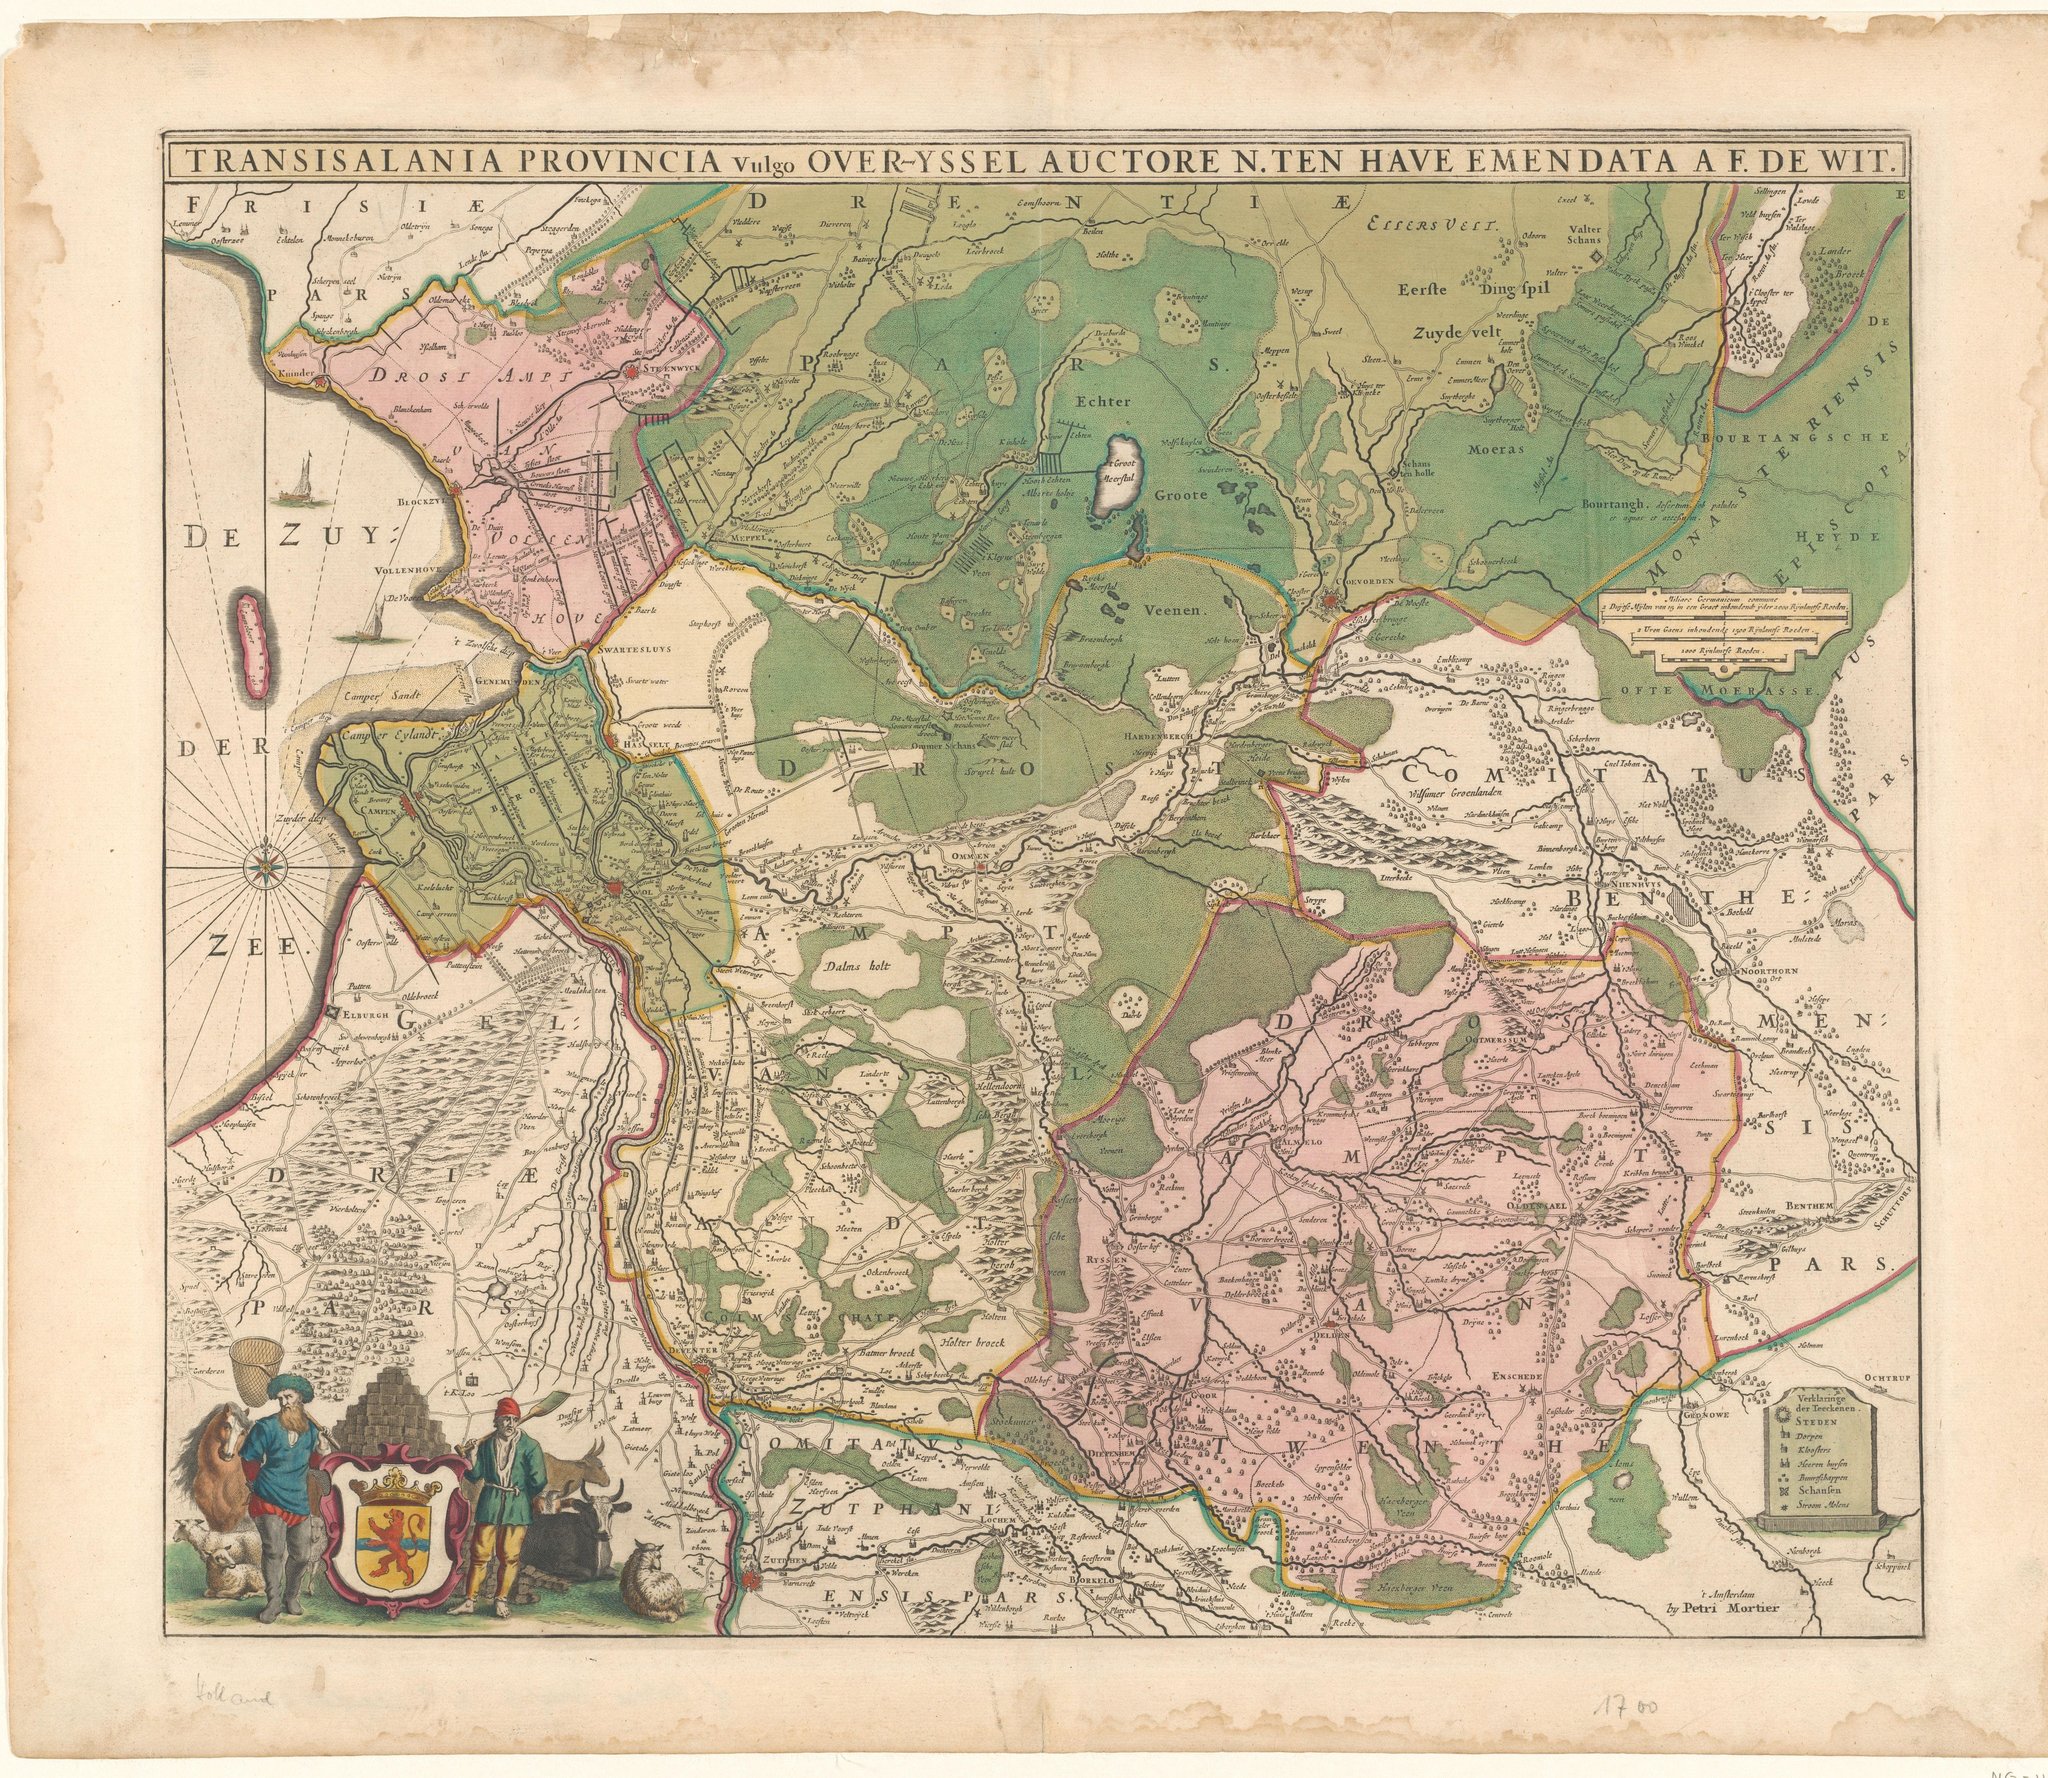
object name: print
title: Kaart van Overijssel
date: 1680-1710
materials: paper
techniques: engraving, etching, hand coloring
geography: amsterdam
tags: peat-cutting, maps of separate countries or regions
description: Kaart van de provincie Overijssel met linksmidden de Zuiderzee met het eiland Emmeloort en een kompasroos. Linksonder het wapen van Overijssel met een visser en een turfsteker als wapendragers. Hierbij ook verschillende dieren de veeteelt symboliserend en een stapel turfblokken. Midden rechts drie schaalstokken.